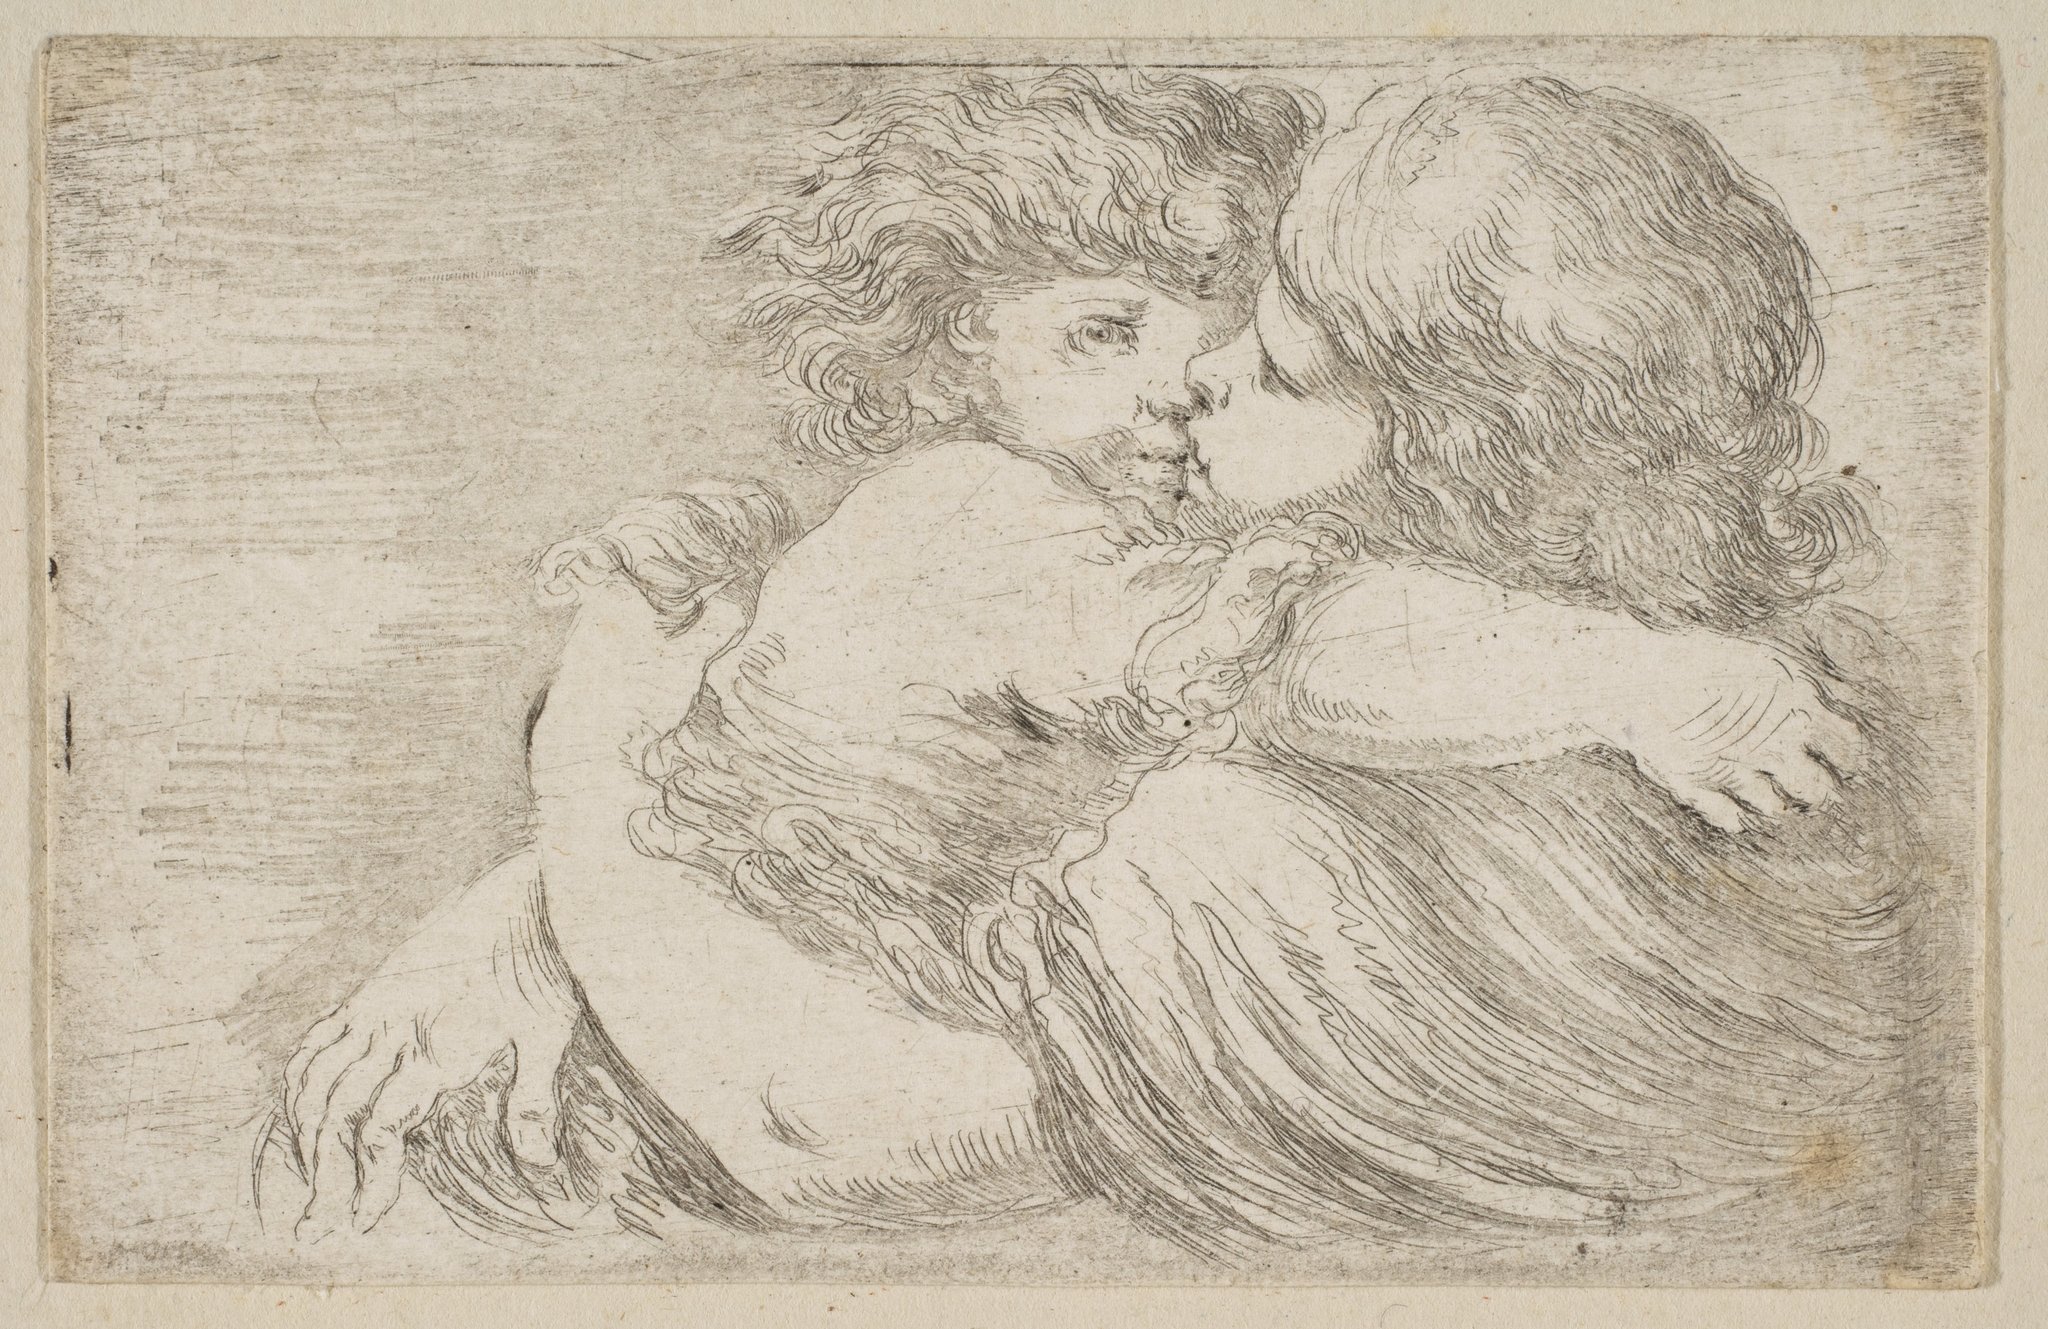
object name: print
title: Two Children Embrace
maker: stefano della bella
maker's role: artist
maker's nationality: italian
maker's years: 1610-1664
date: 1662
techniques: etching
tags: children